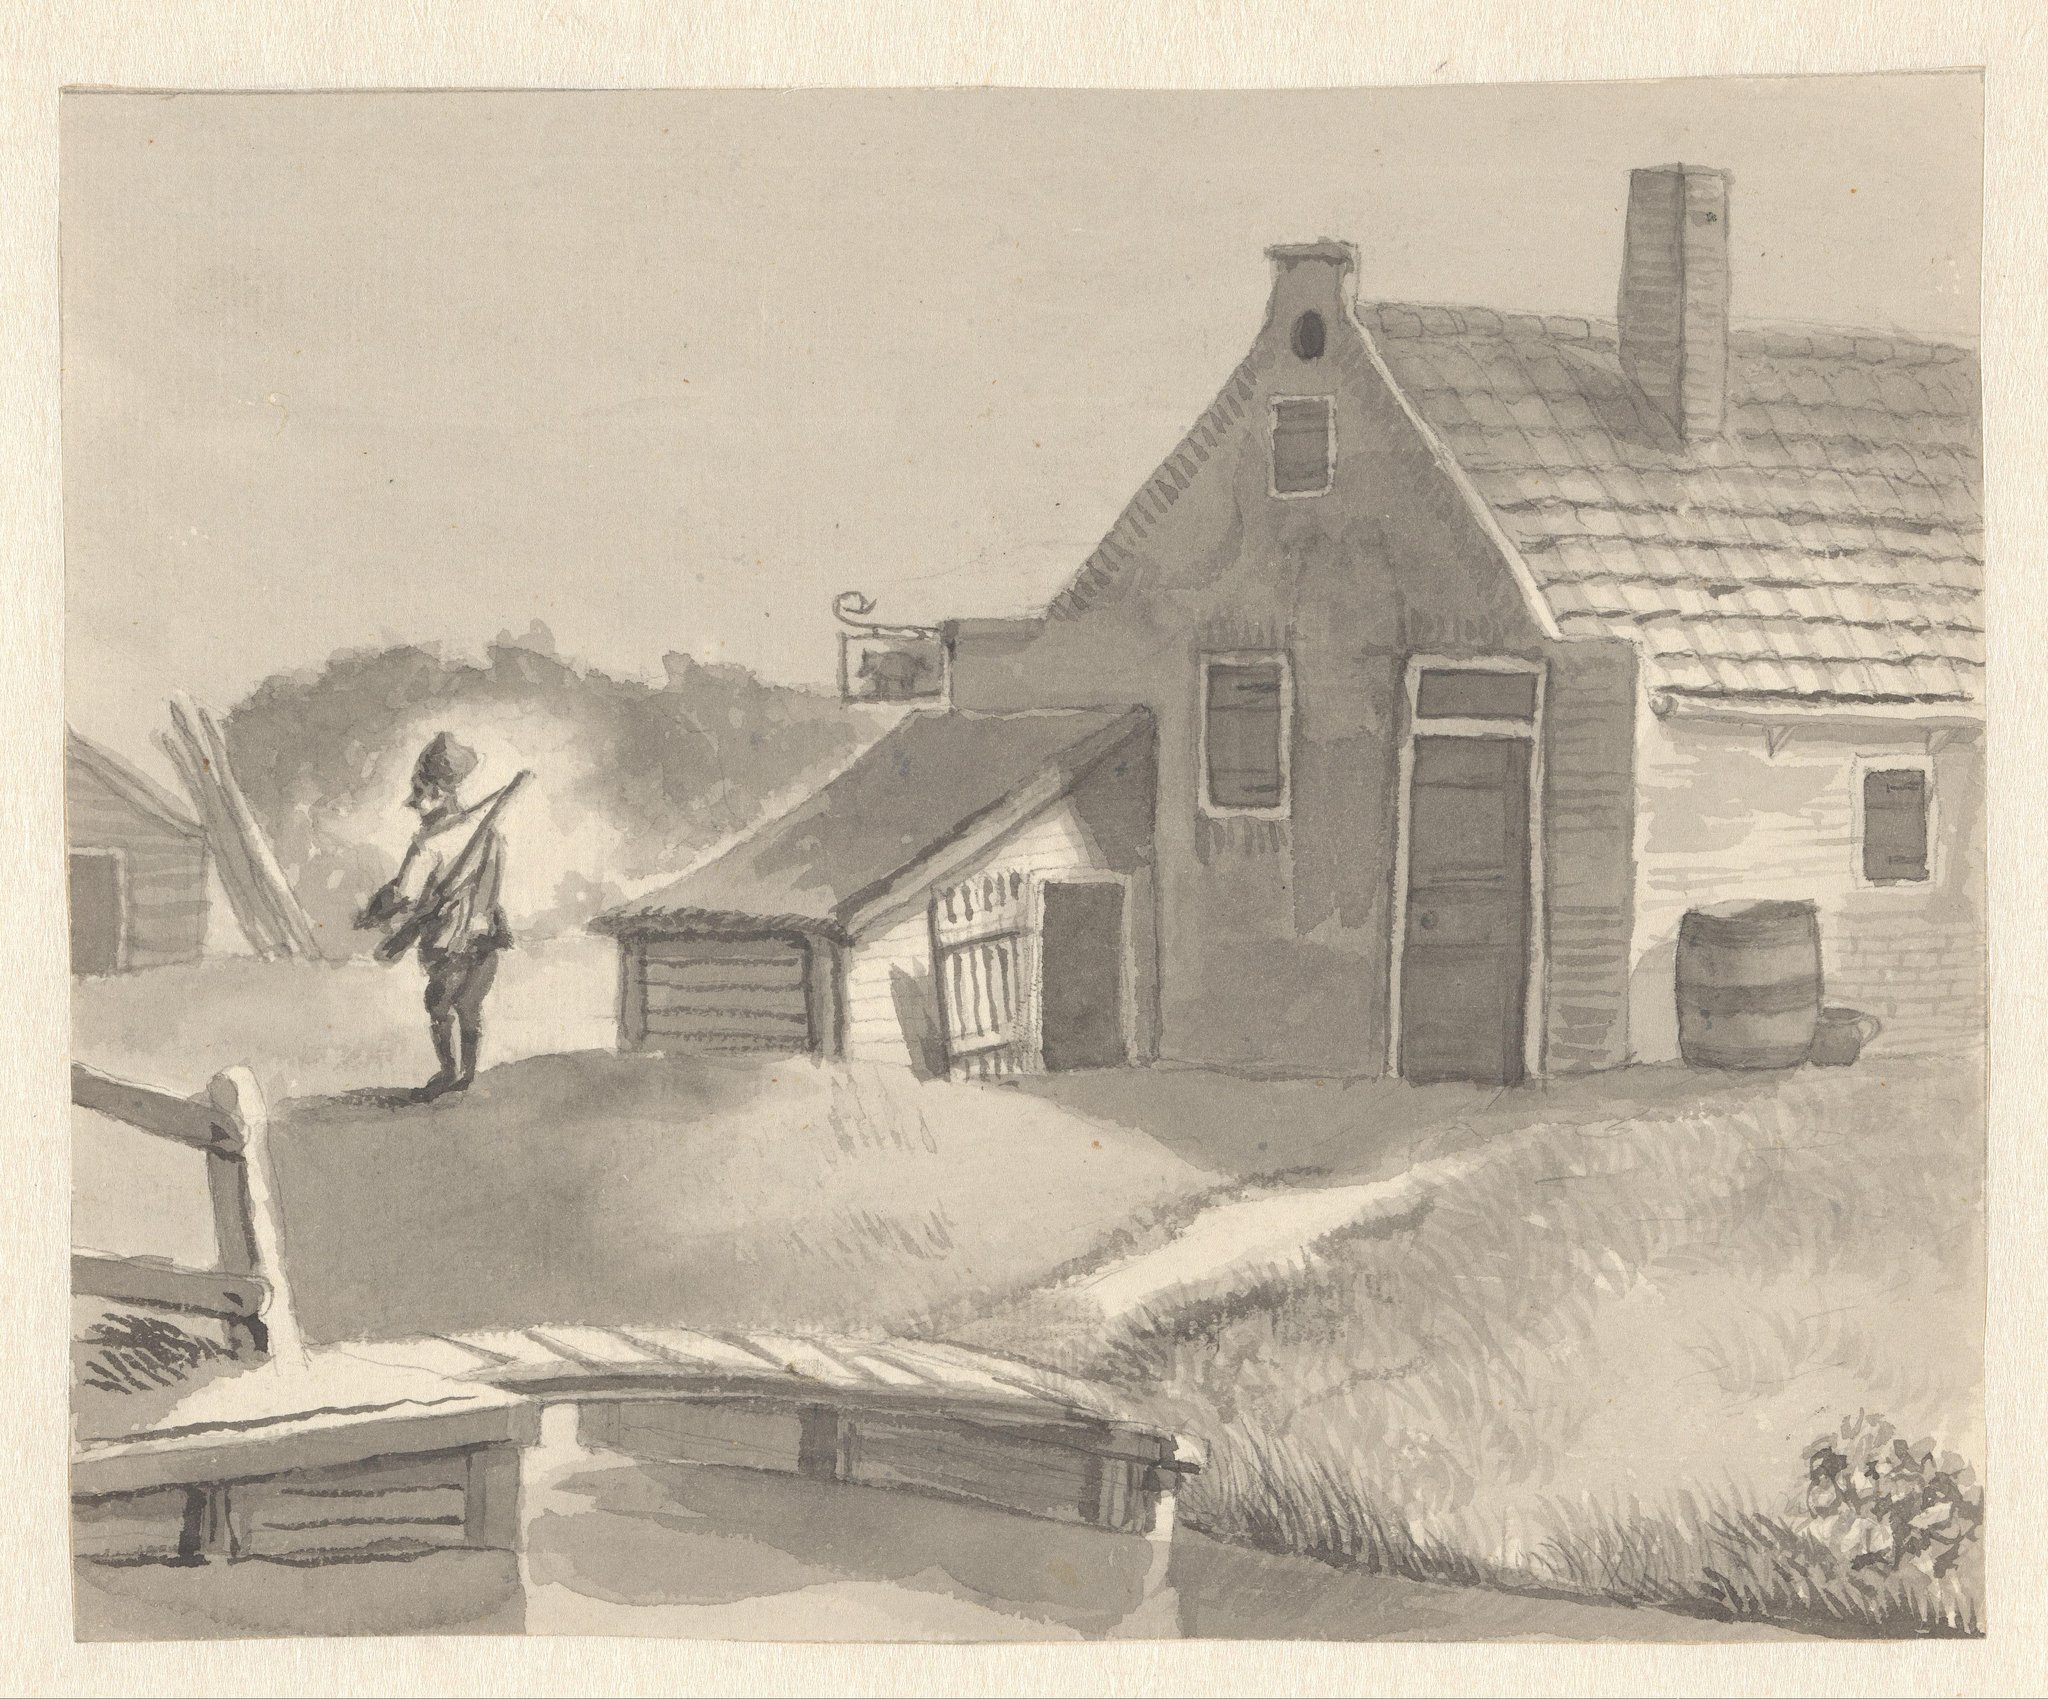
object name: drawing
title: Soldaat bij een herberg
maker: joannes carolus alberdingk thijm (jan)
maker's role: pater, schrijver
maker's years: 1847-1926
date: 1853-1860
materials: ink, paper, pencil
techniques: brush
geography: netherlands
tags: inn, coffee-house, public house, etc., the soldier; the soldier's life